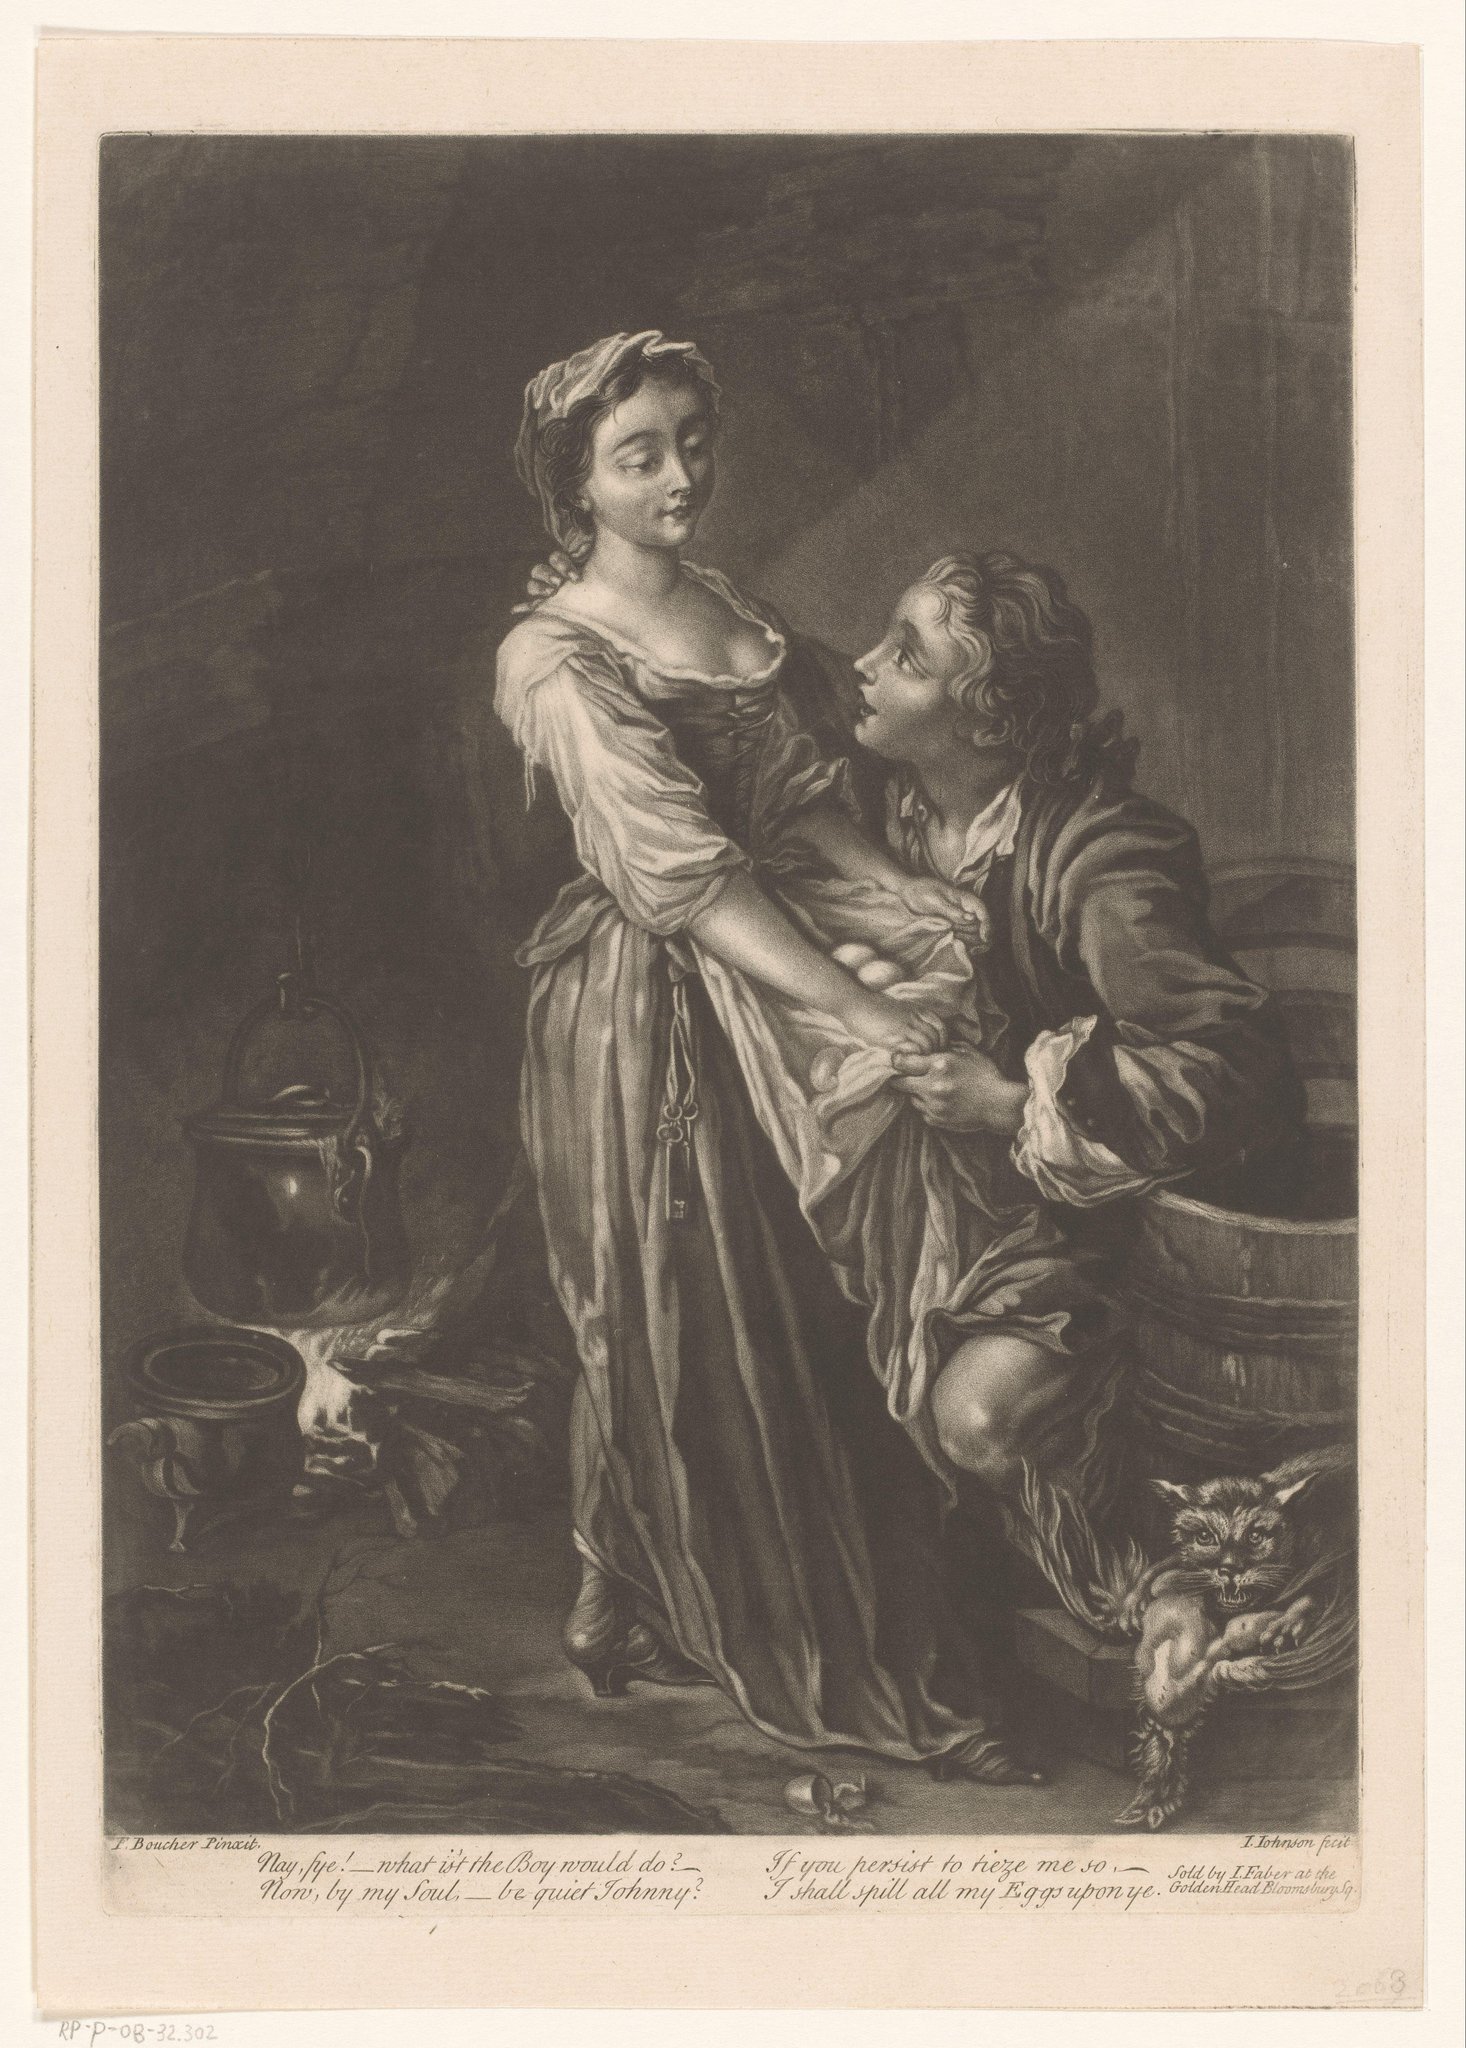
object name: print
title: Keukenmeid en haar minnaar bij een kookvuur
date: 1743-1756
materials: paper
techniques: mezzotint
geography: london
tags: kitchen-maid, kitchen servant, lovers; courting, flirting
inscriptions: collector's mark: Lugt 240